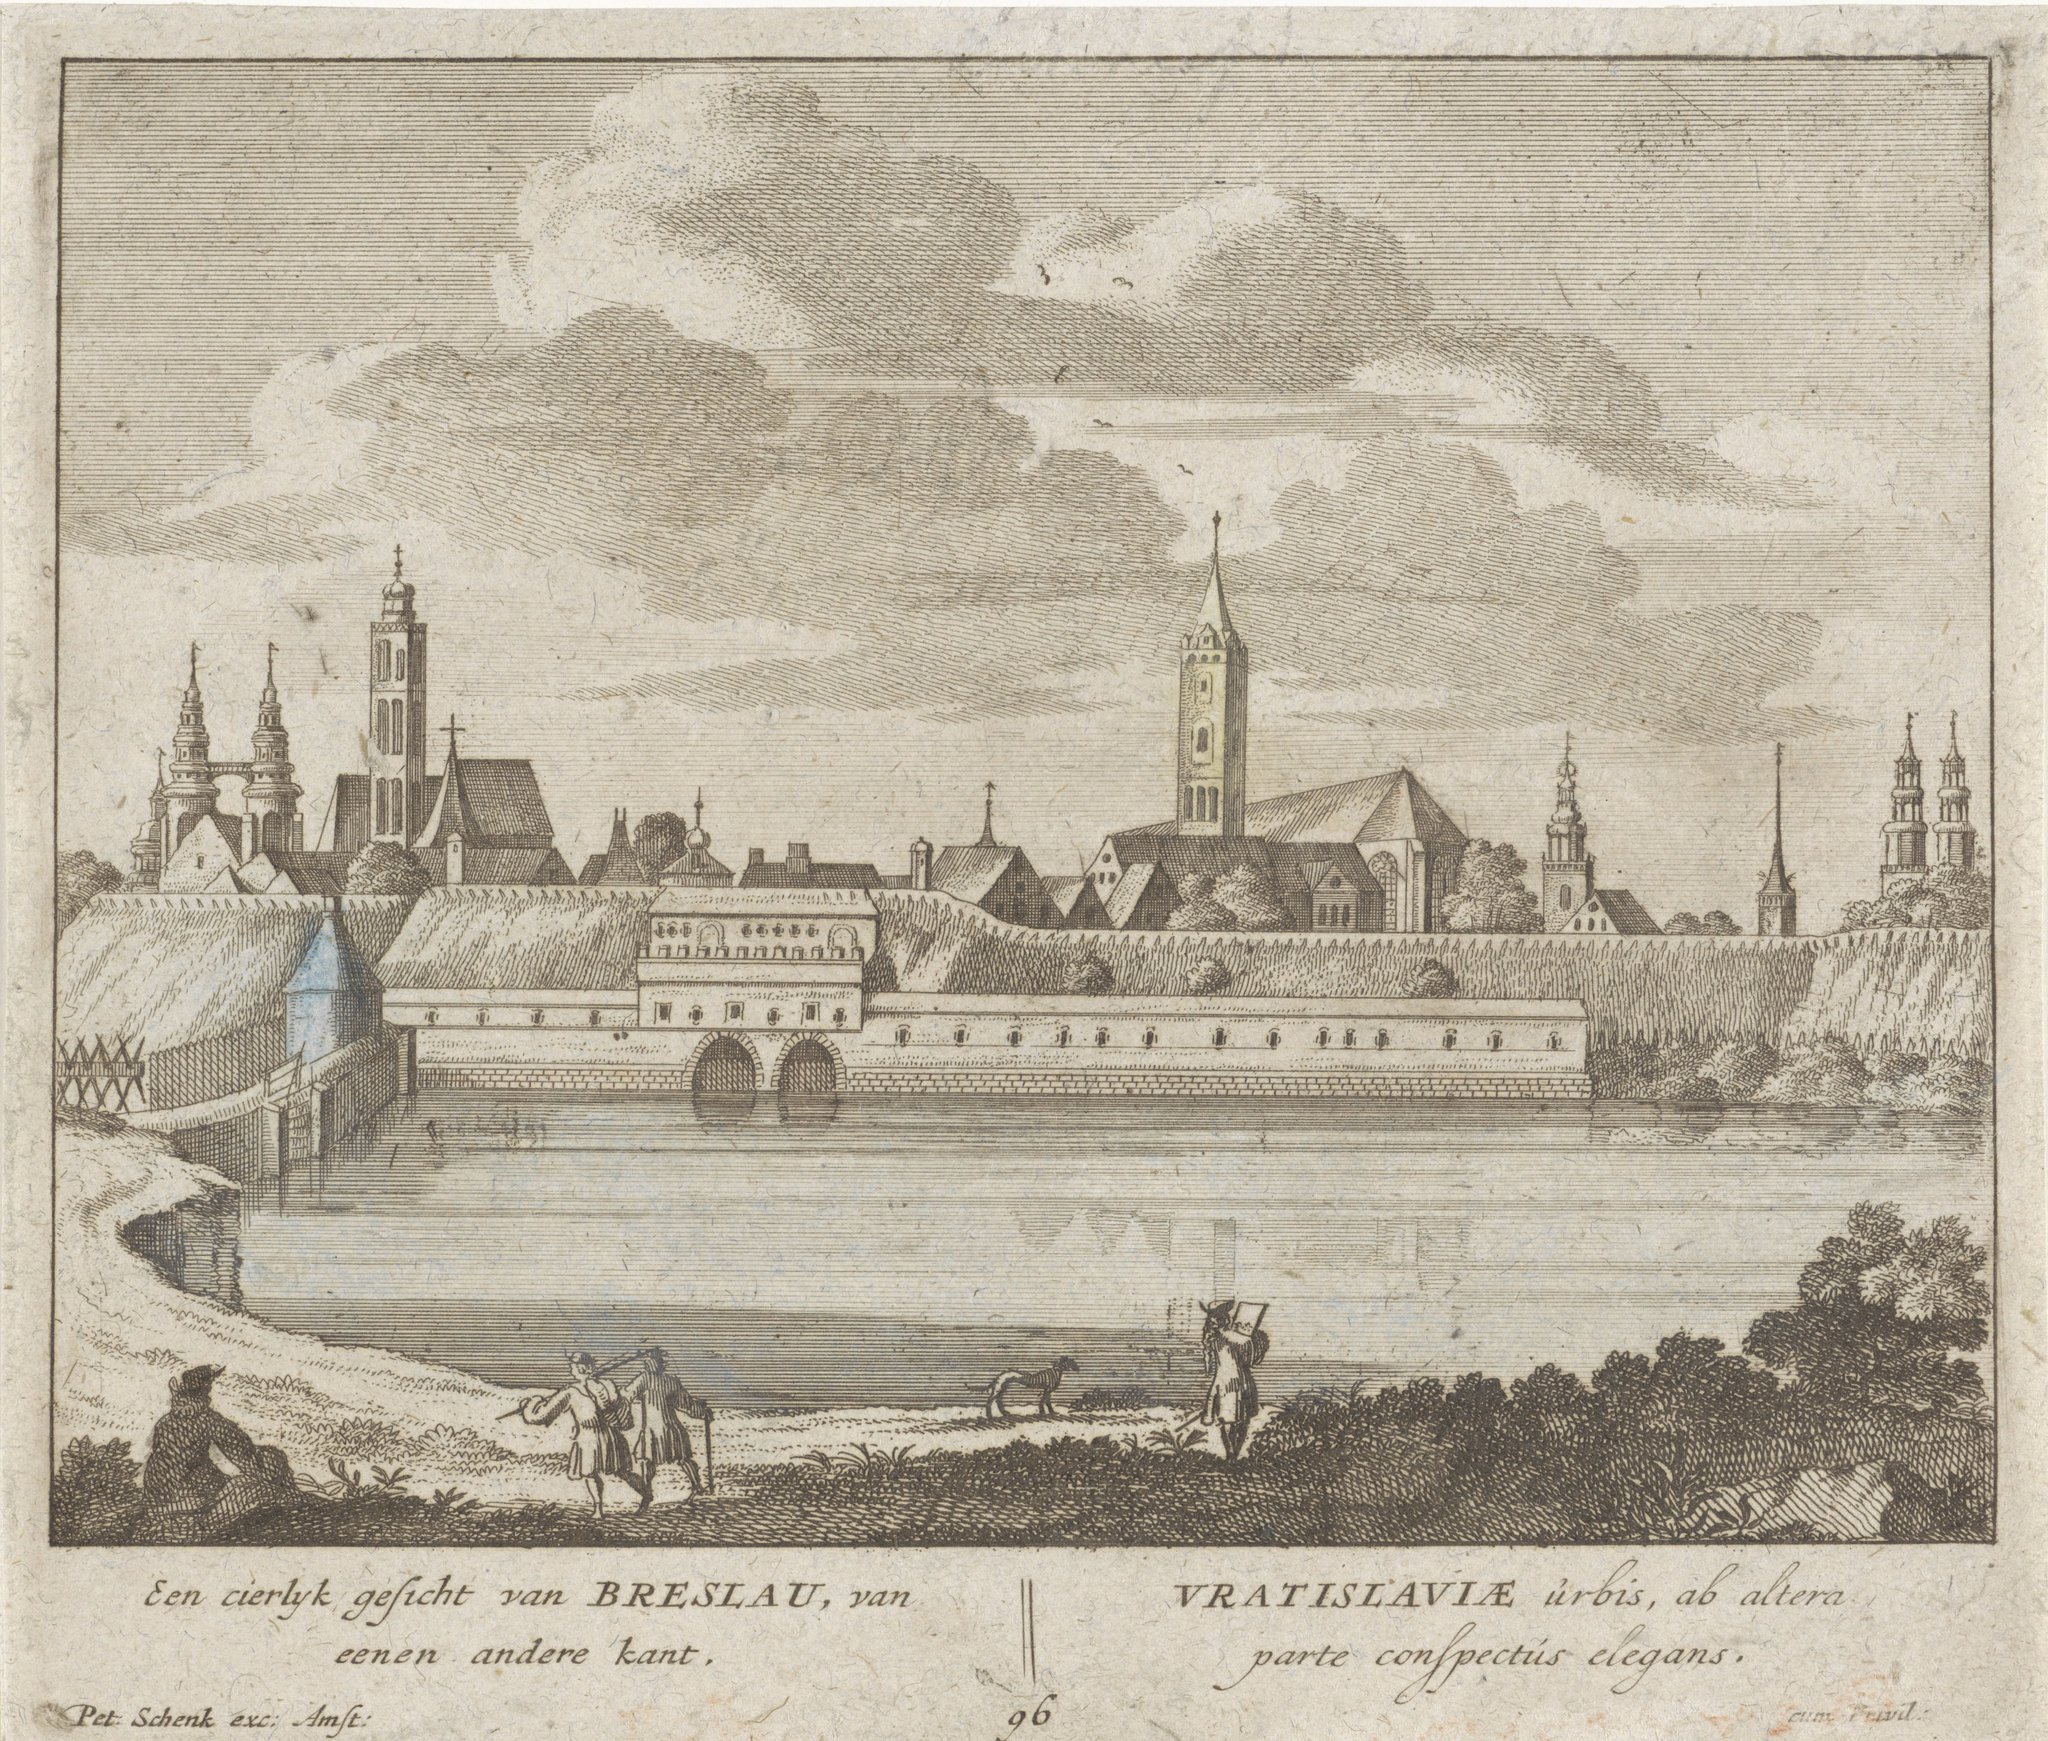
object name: print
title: Een cierlyk gesicht van Breslau, van eenen andere kant.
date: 1675-1711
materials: paper, pencil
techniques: etching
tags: river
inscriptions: collector's mark: Lugt 2228